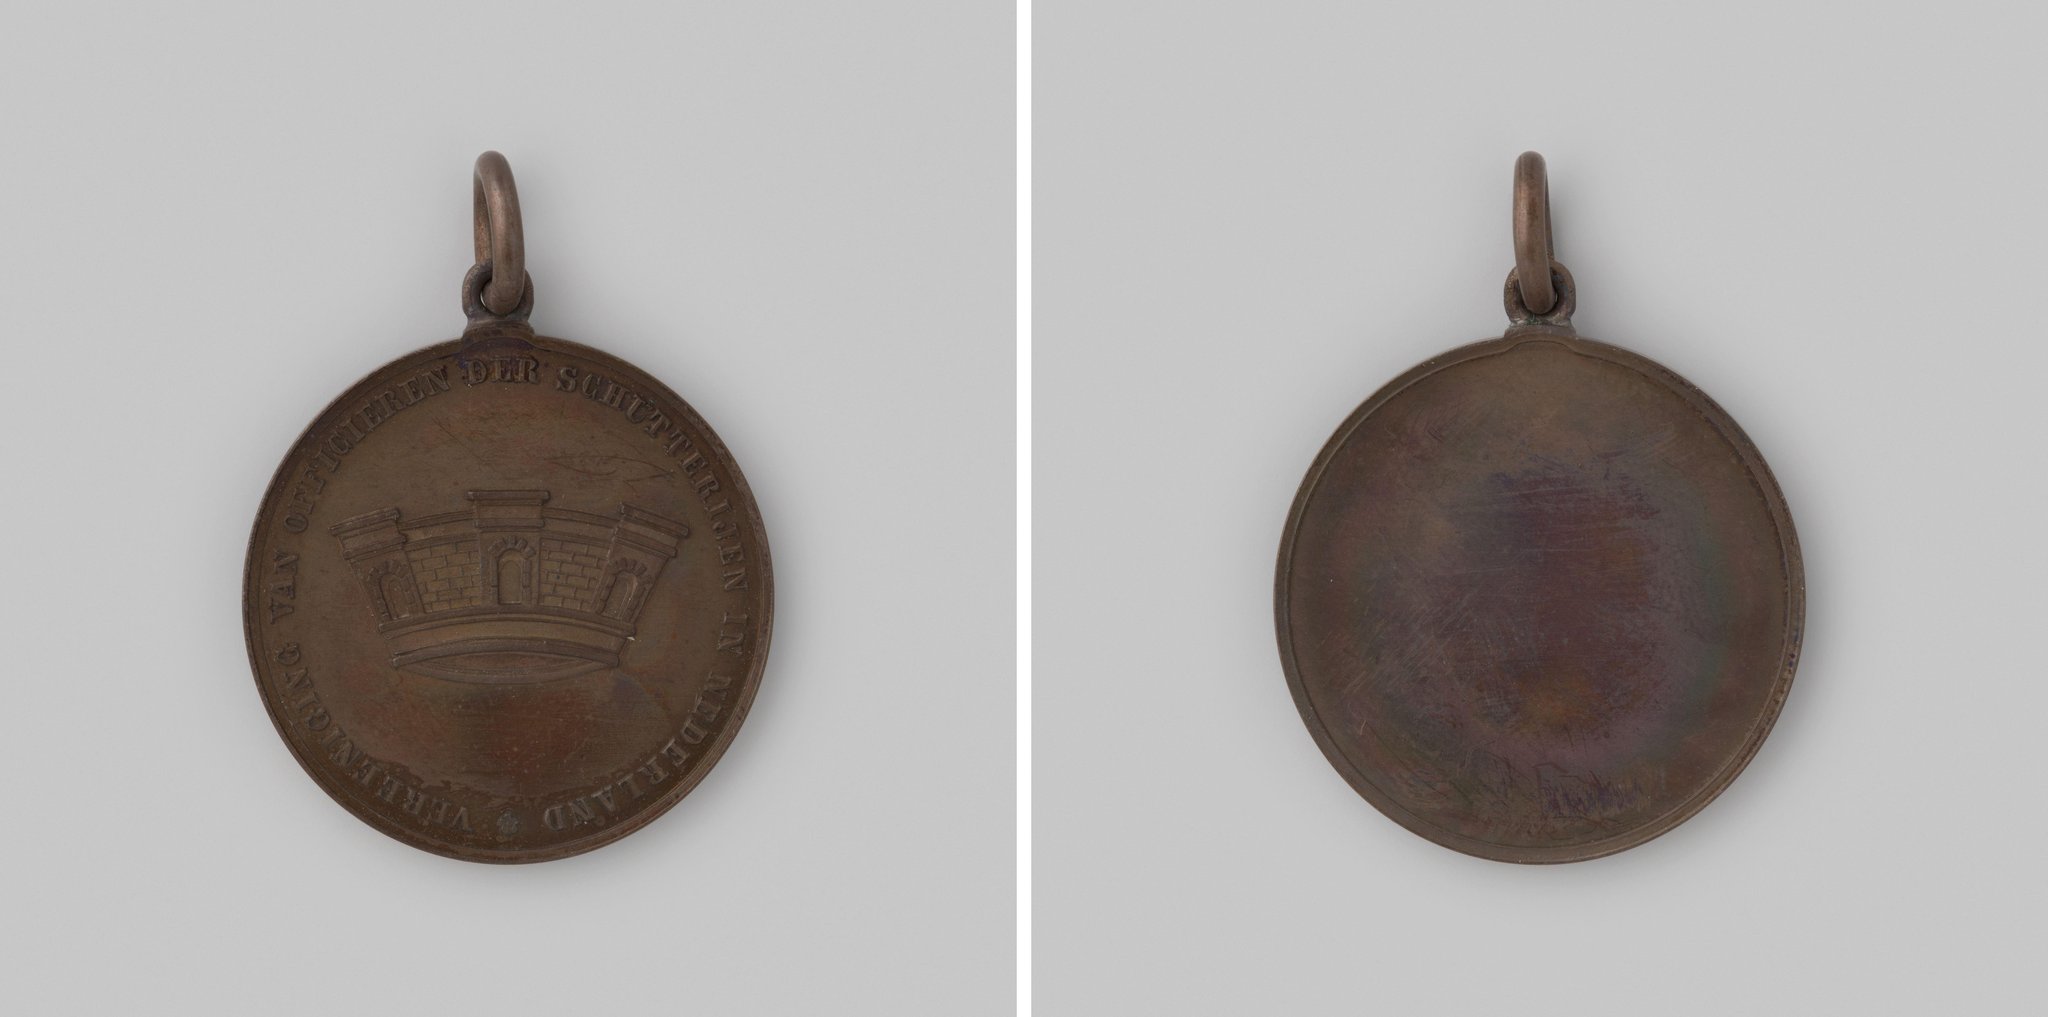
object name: medal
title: Prijspenning van de Vereeniging van Officieren der Schutterijen in Nederland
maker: Anonymous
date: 1870-1900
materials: bronze, metal